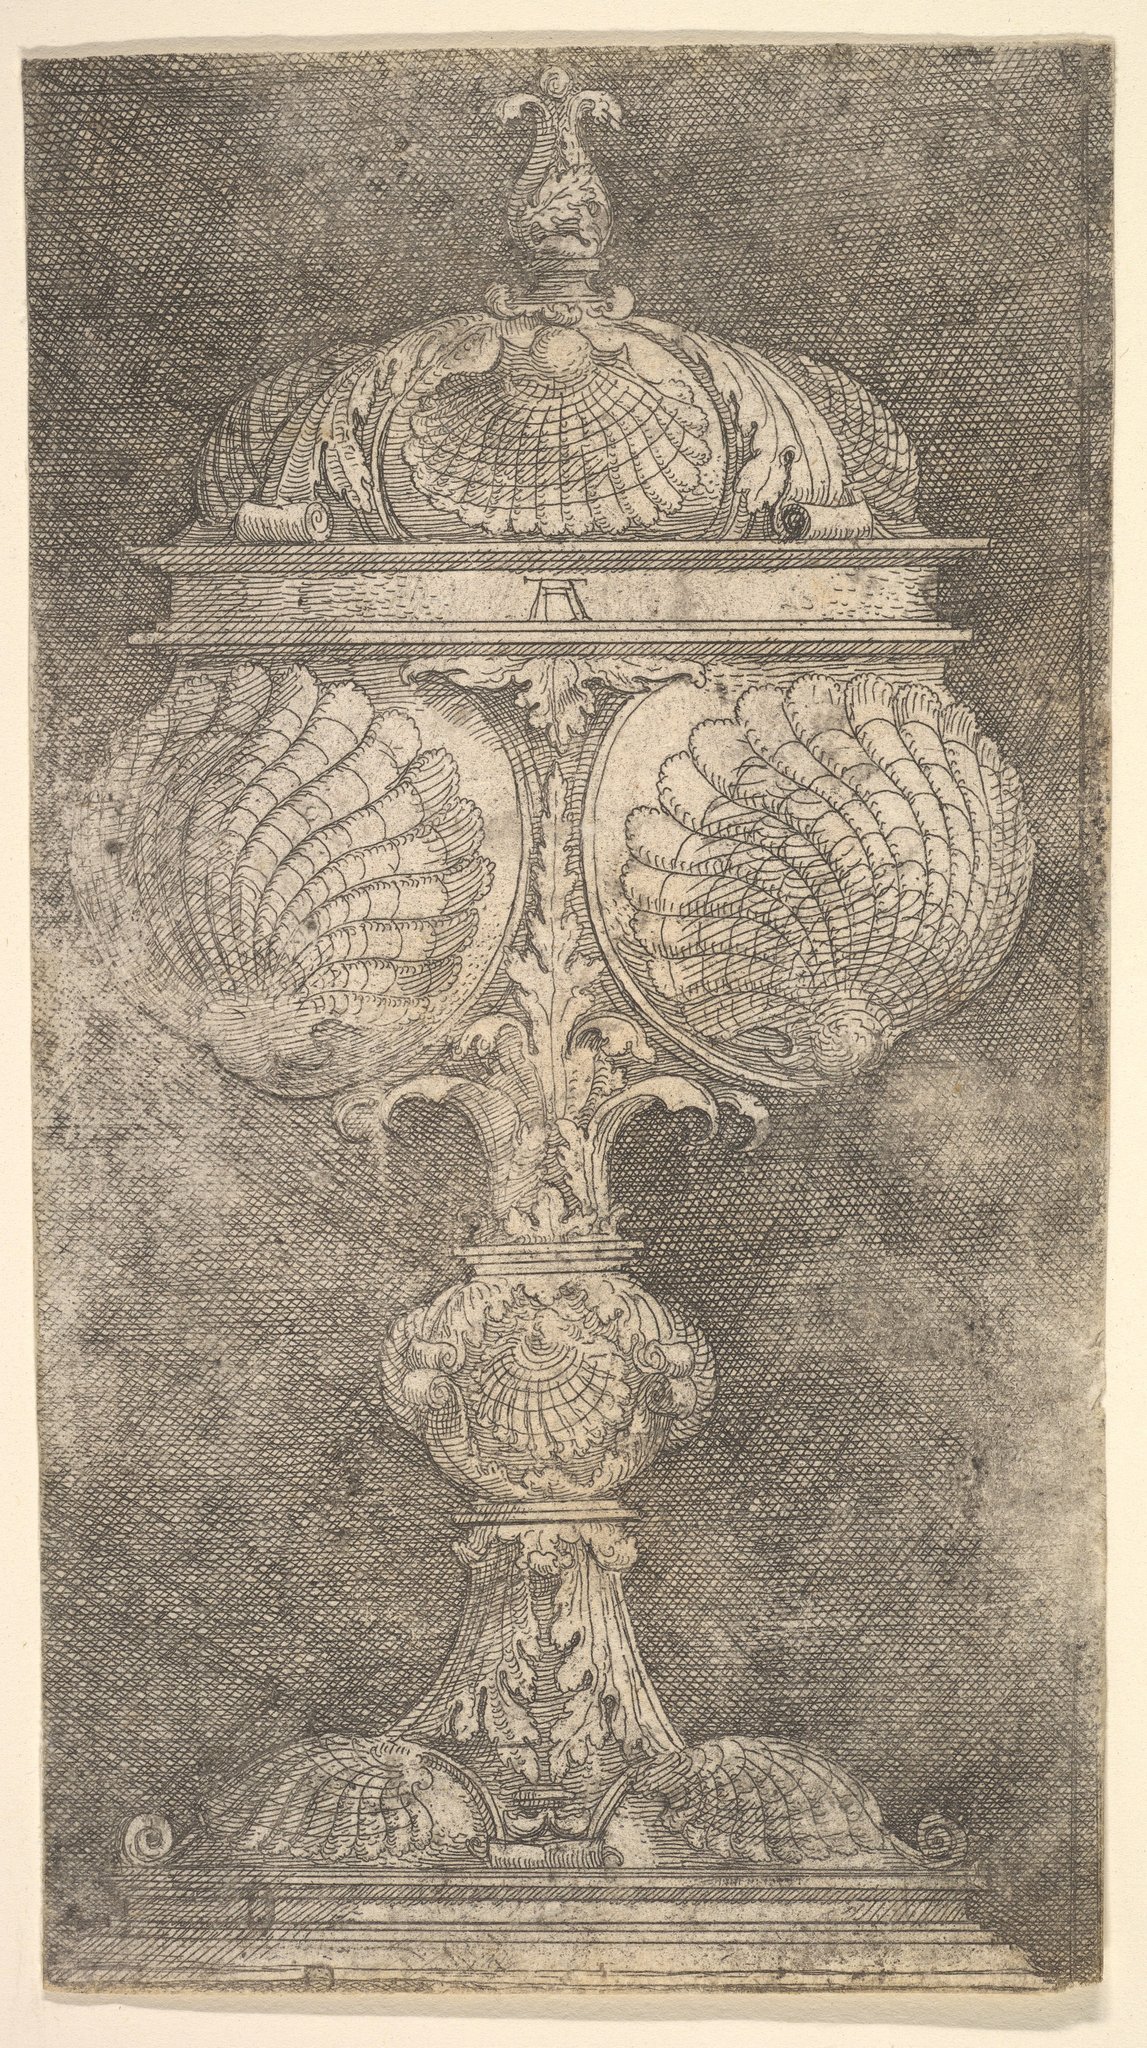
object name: print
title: Covered Goblet with Shells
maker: albrecht altdorfer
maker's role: artist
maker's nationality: german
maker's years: 1480-1538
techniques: etching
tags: shells,drinking glasses